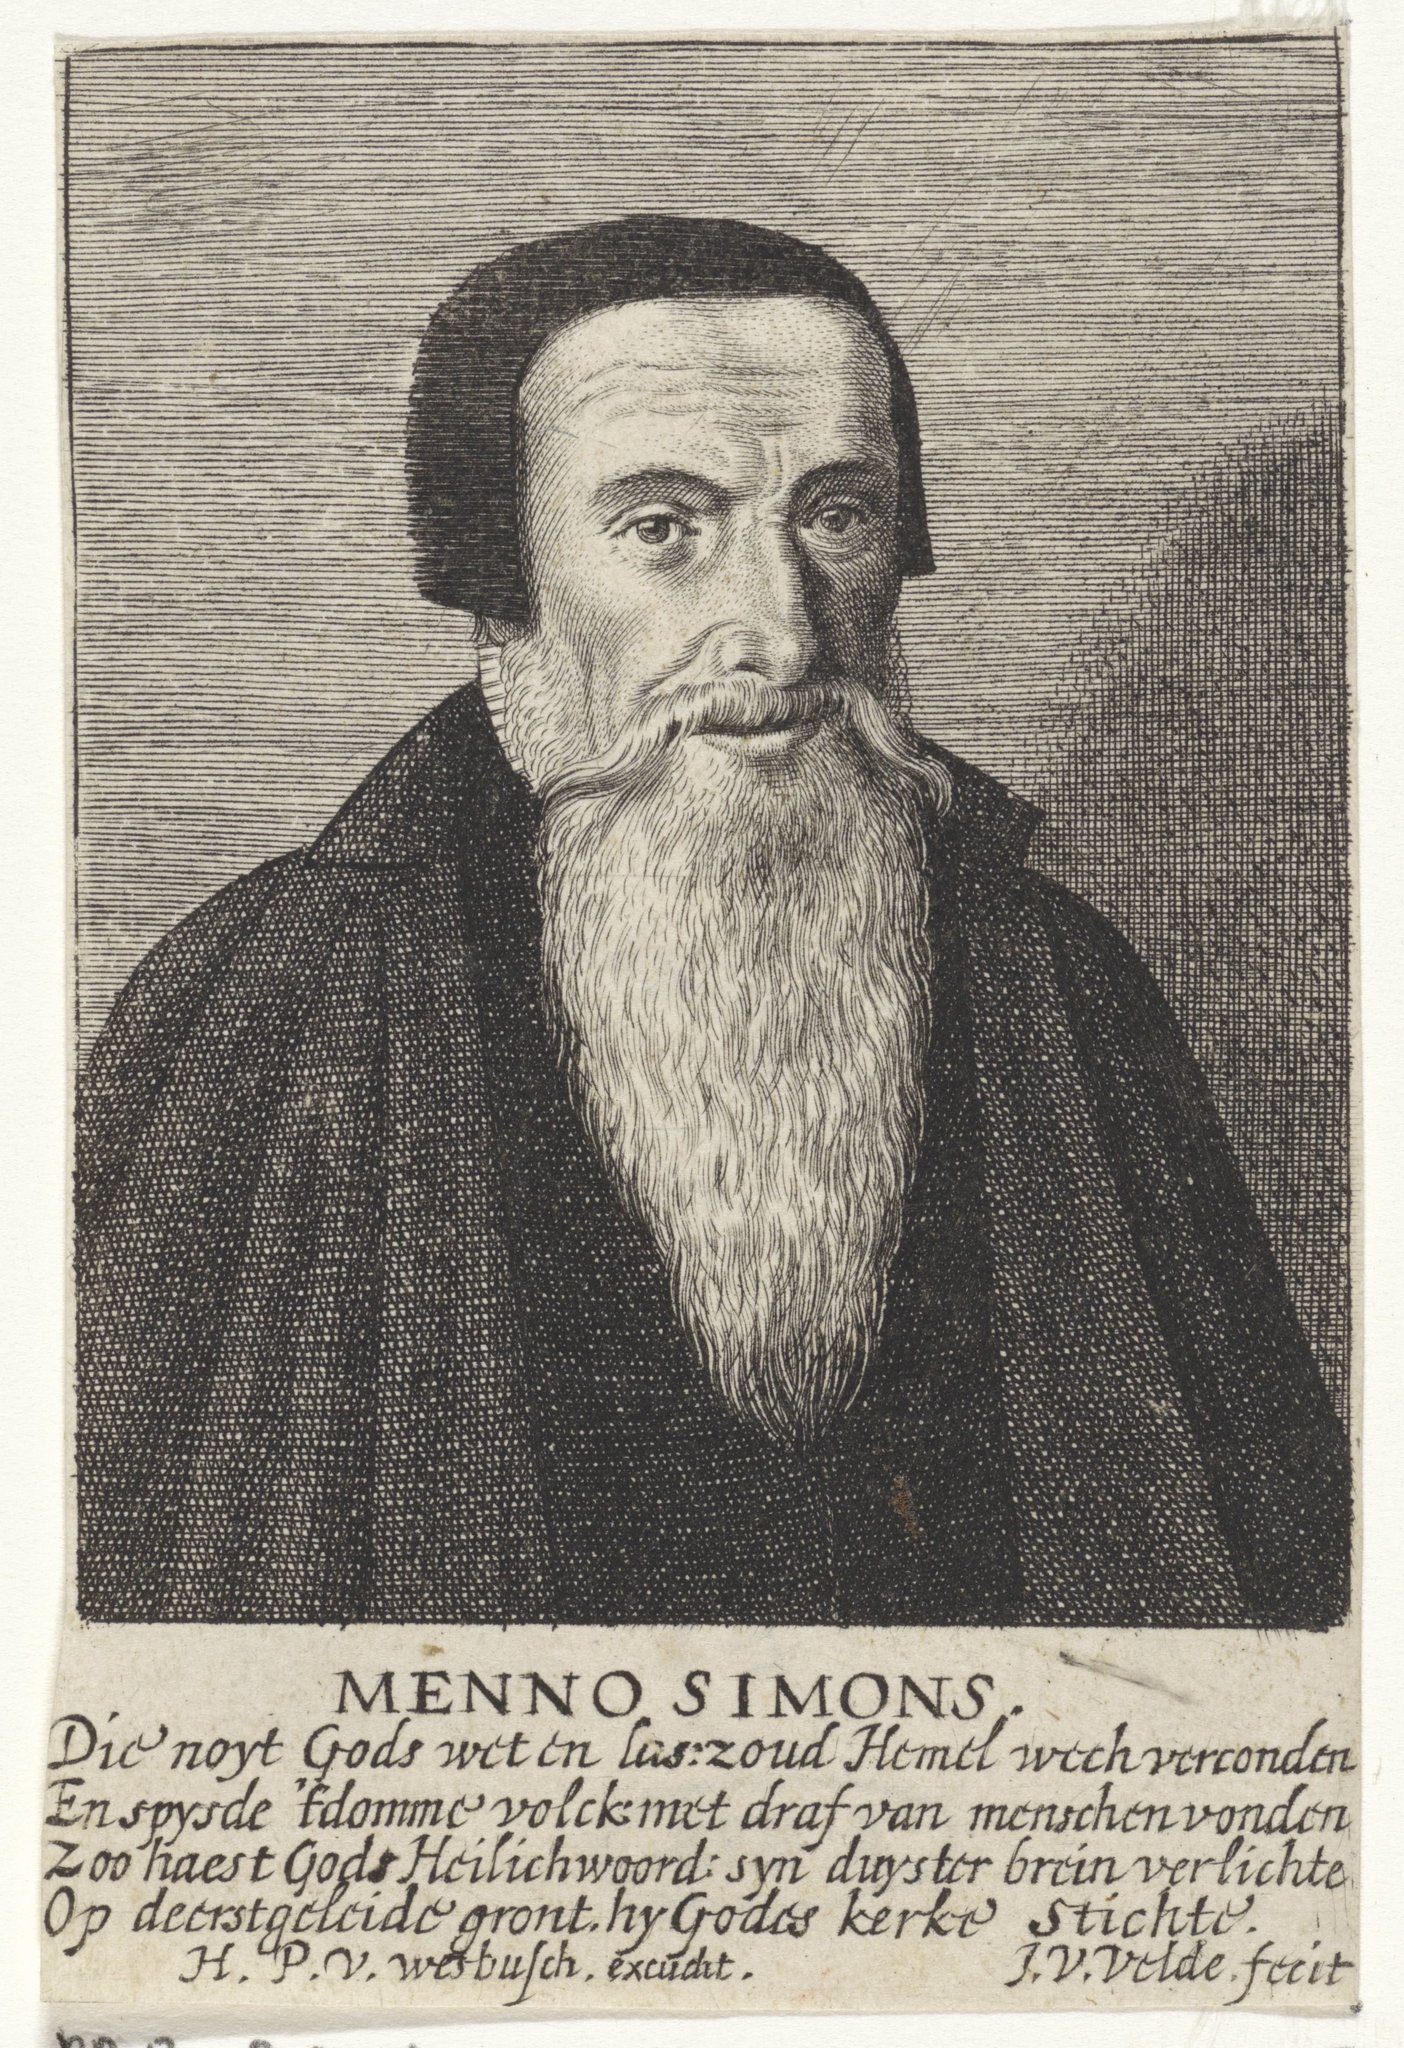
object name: print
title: Portret van Menno Simons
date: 1623-1641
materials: paper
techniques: engraving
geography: haarlem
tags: clergyman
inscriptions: collector's mark: Lugt 964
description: Portret van Menno Simons, leider van de Mennonieten (doopsgezinden).